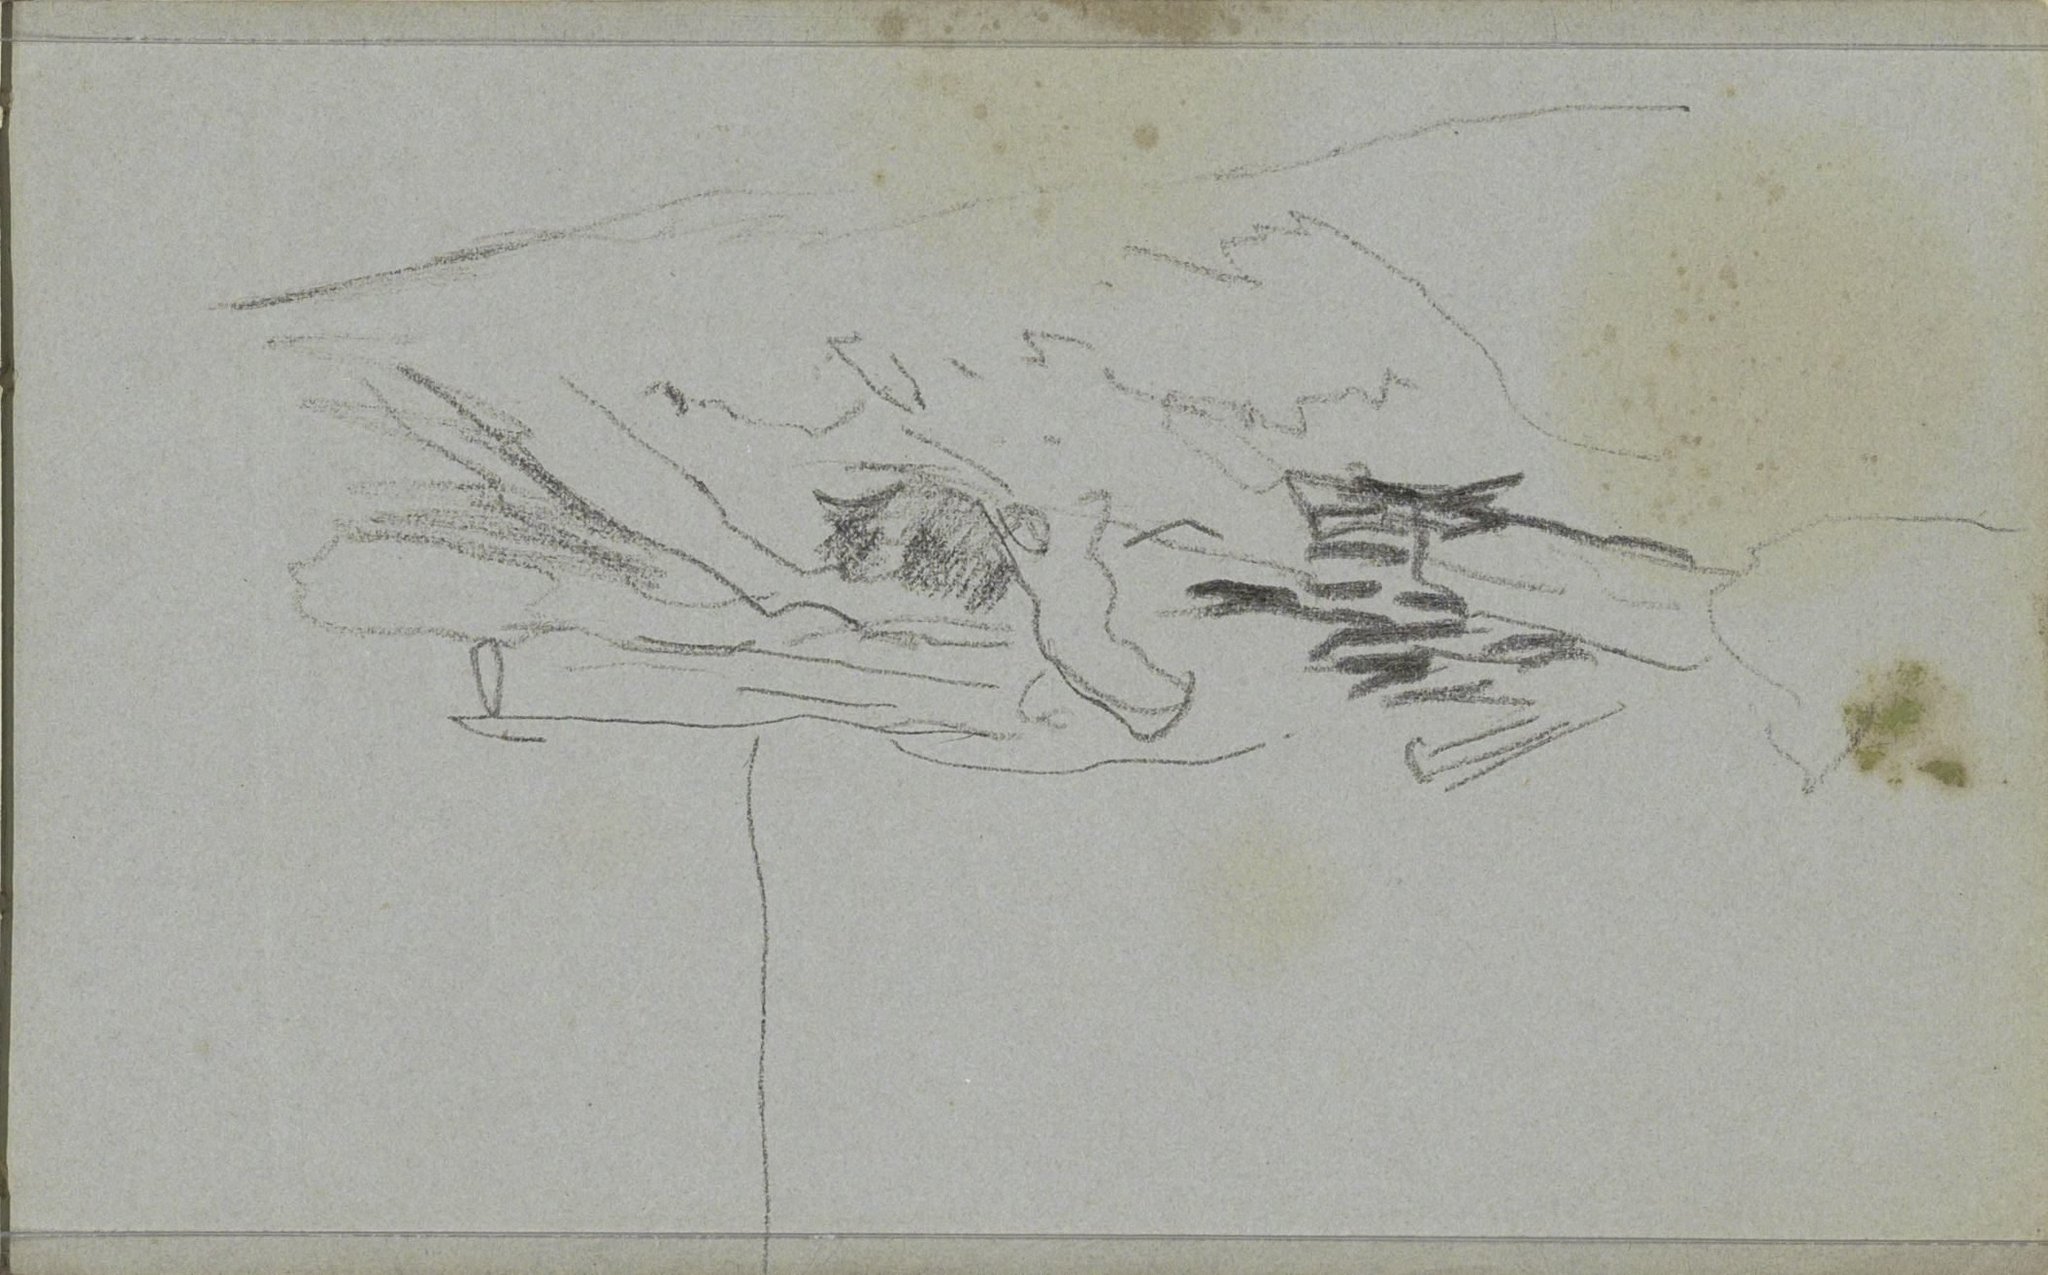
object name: sketchbook leaf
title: Sprokkelhout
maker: anton mauve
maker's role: draughtsman, painter, print maker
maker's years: 1838-1888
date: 1848-1888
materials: chalk, paper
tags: trees (+ branch, stick)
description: Blad 39 recto uit een schetsboek met 44 bladen.